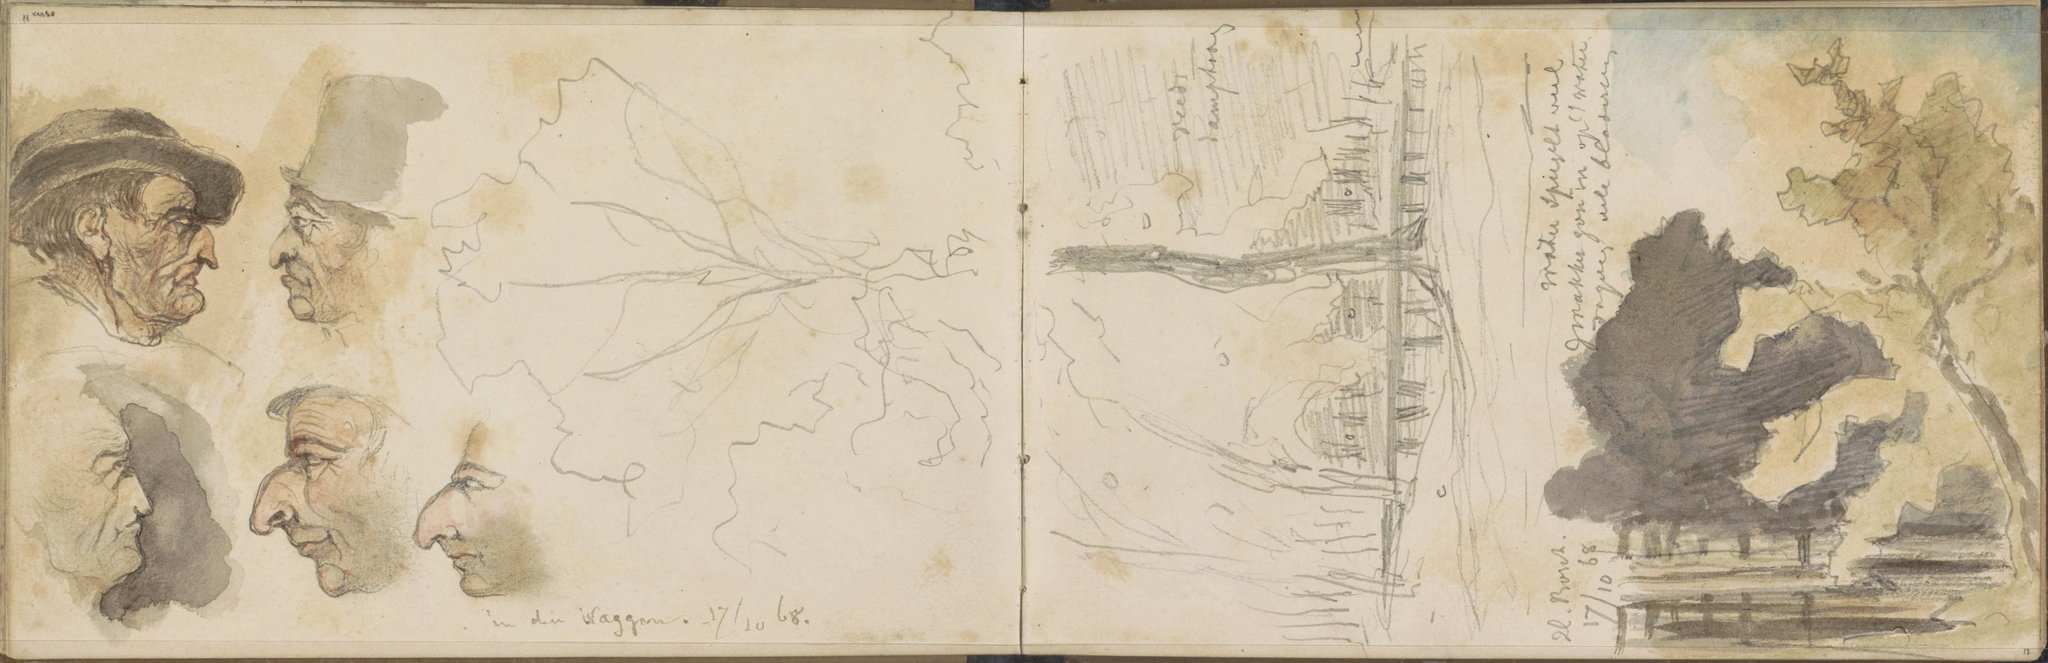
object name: sketchbook leaf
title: Haagse Bos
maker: johannes tavenraat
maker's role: draughtsman, painter, print maker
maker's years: 1809-1881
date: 1810-1868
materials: paper, pencil, watercolor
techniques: brush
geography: the hague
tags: forest, wood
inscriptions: date and inscription: ‘H. Bosch/ 17/10 68’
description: Blad 12 recto uit een schetsboek met 48 bladen.